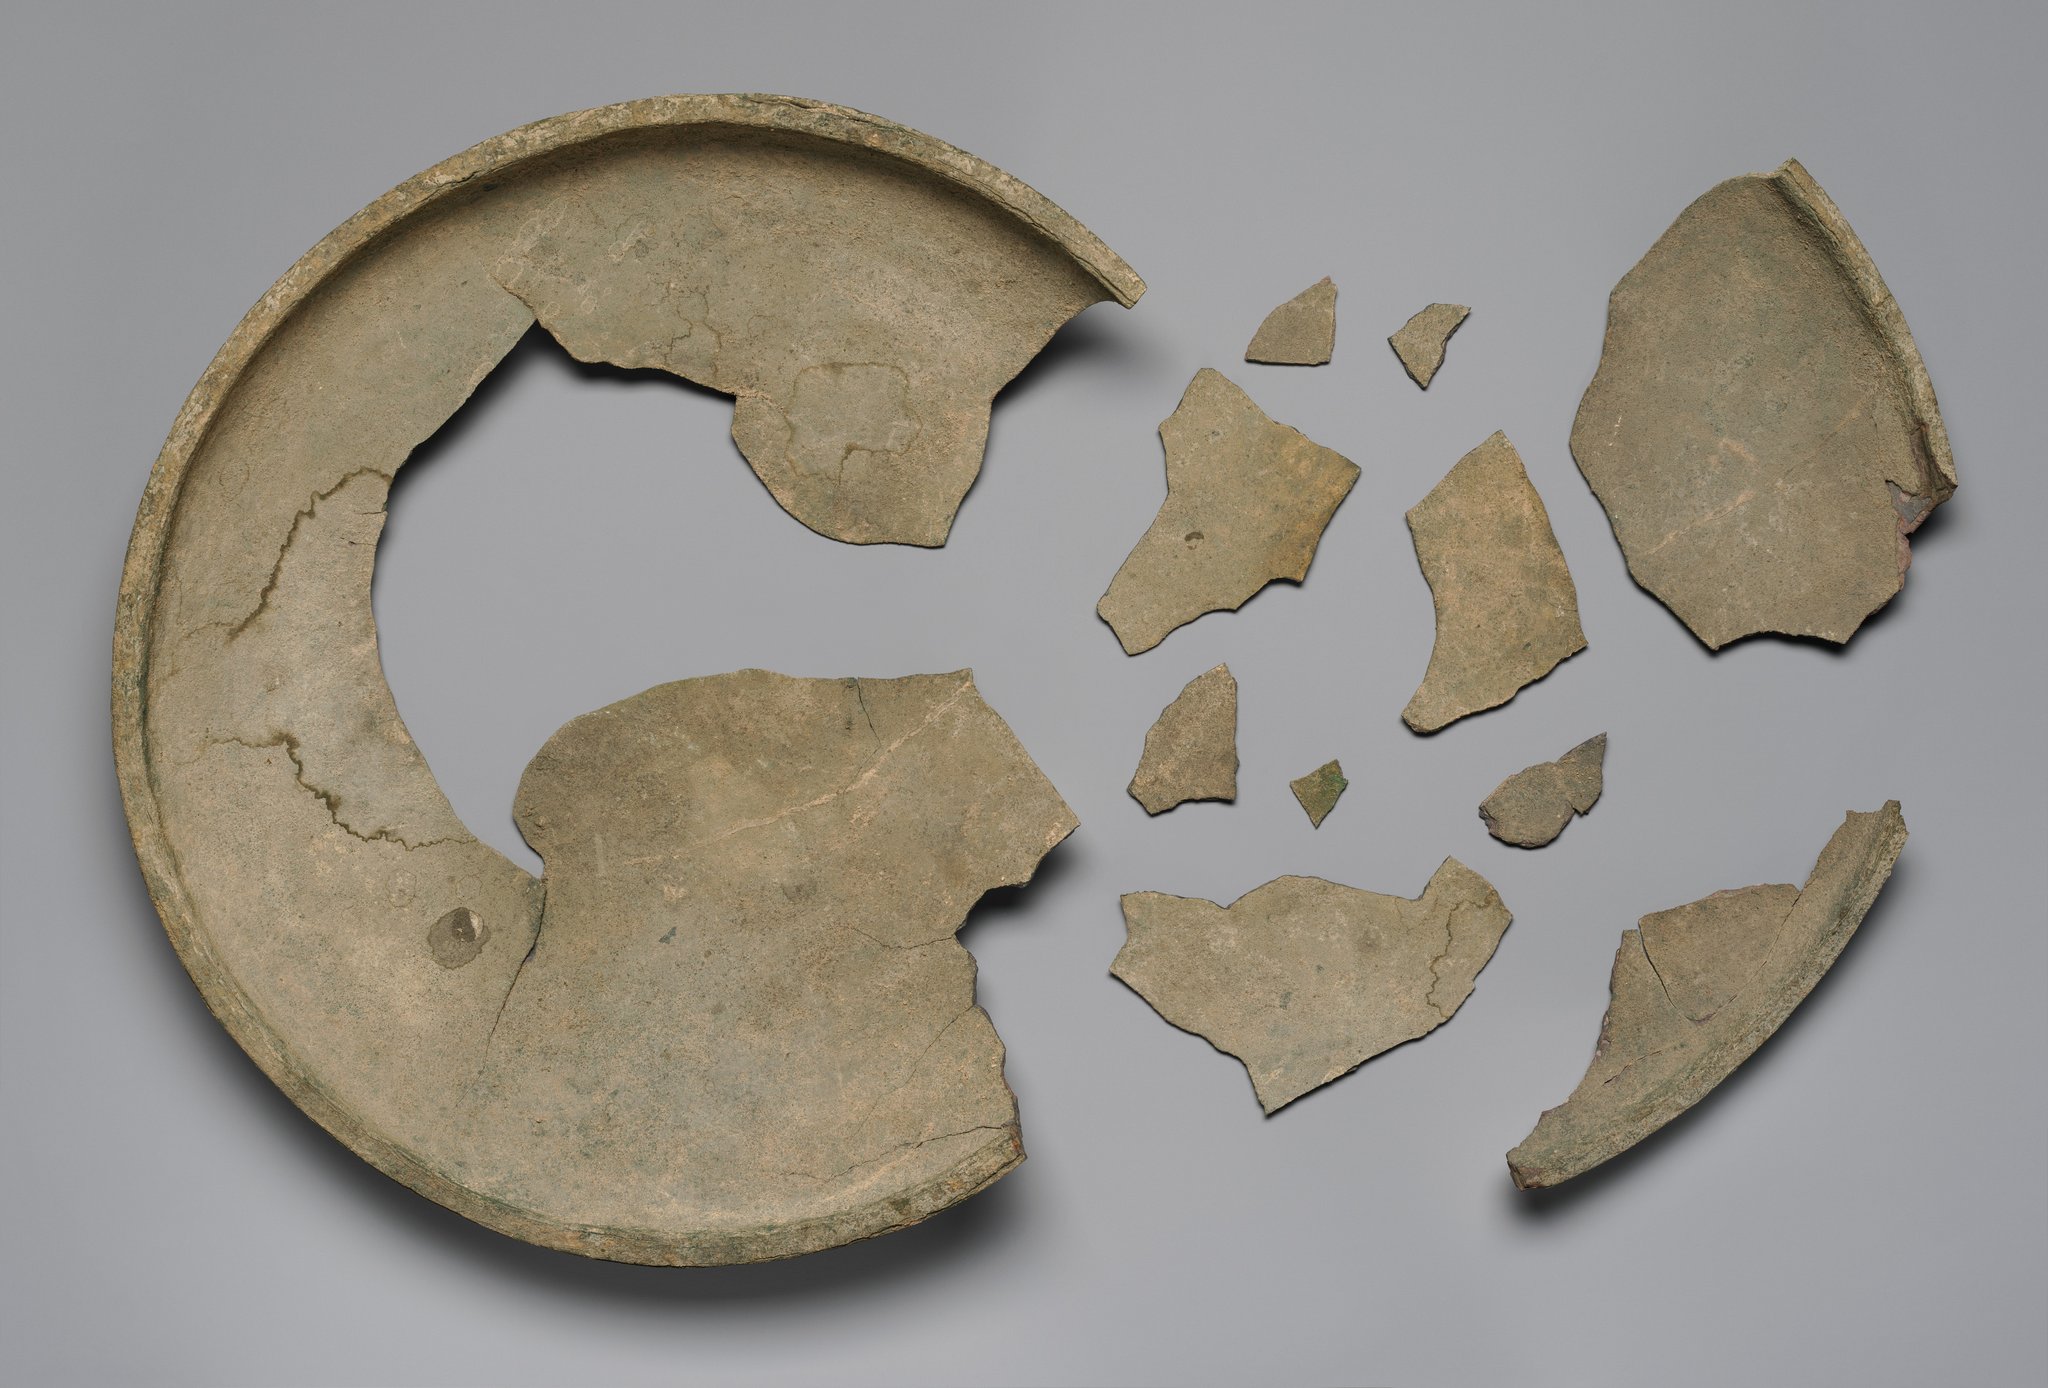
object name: bowl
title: Bronze bowl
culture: sasanian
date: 201-700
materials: bronze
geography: iran